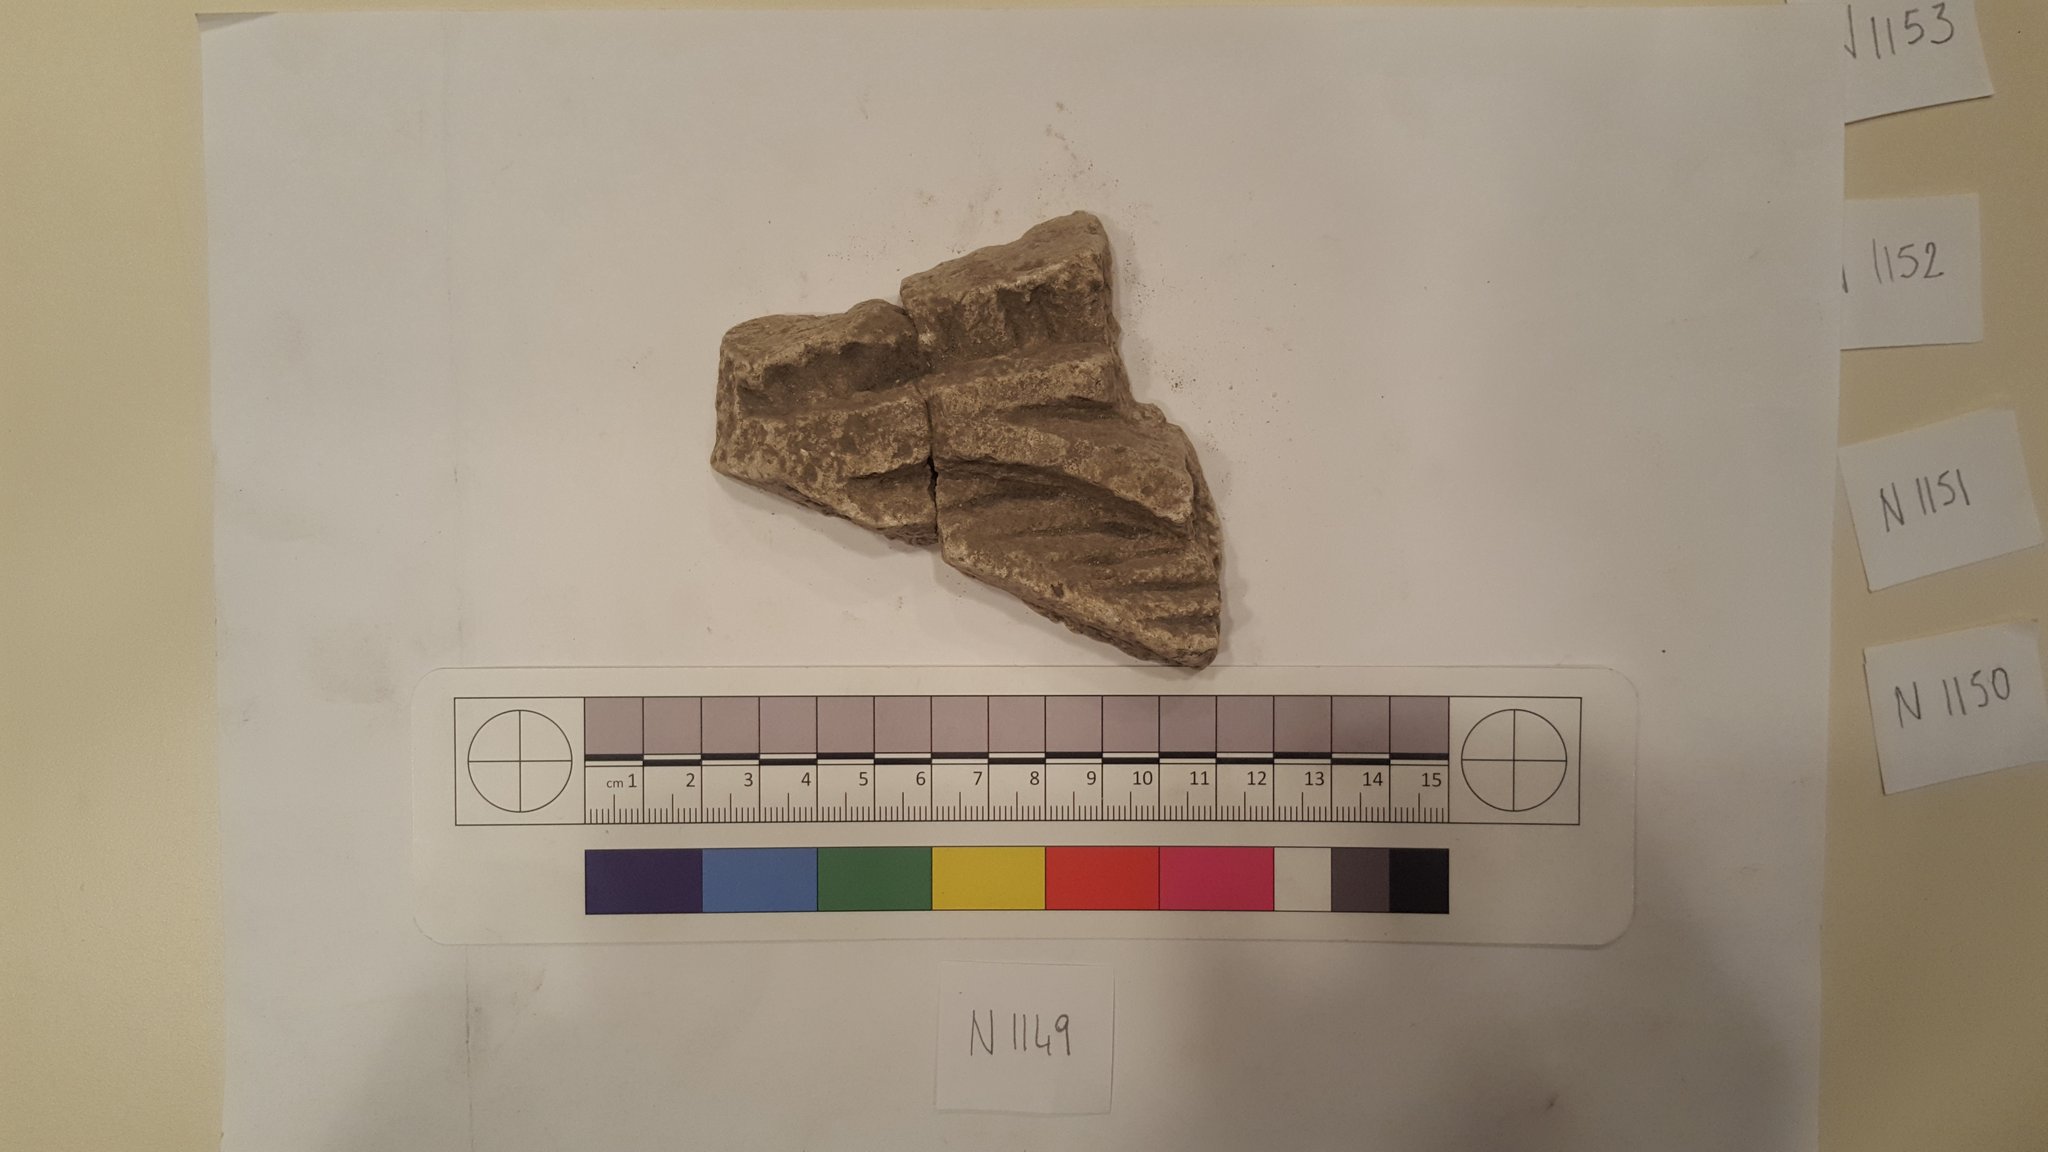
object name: fragment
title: Stucco Fragment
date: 701-1200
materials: plaster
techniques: carving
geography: iran